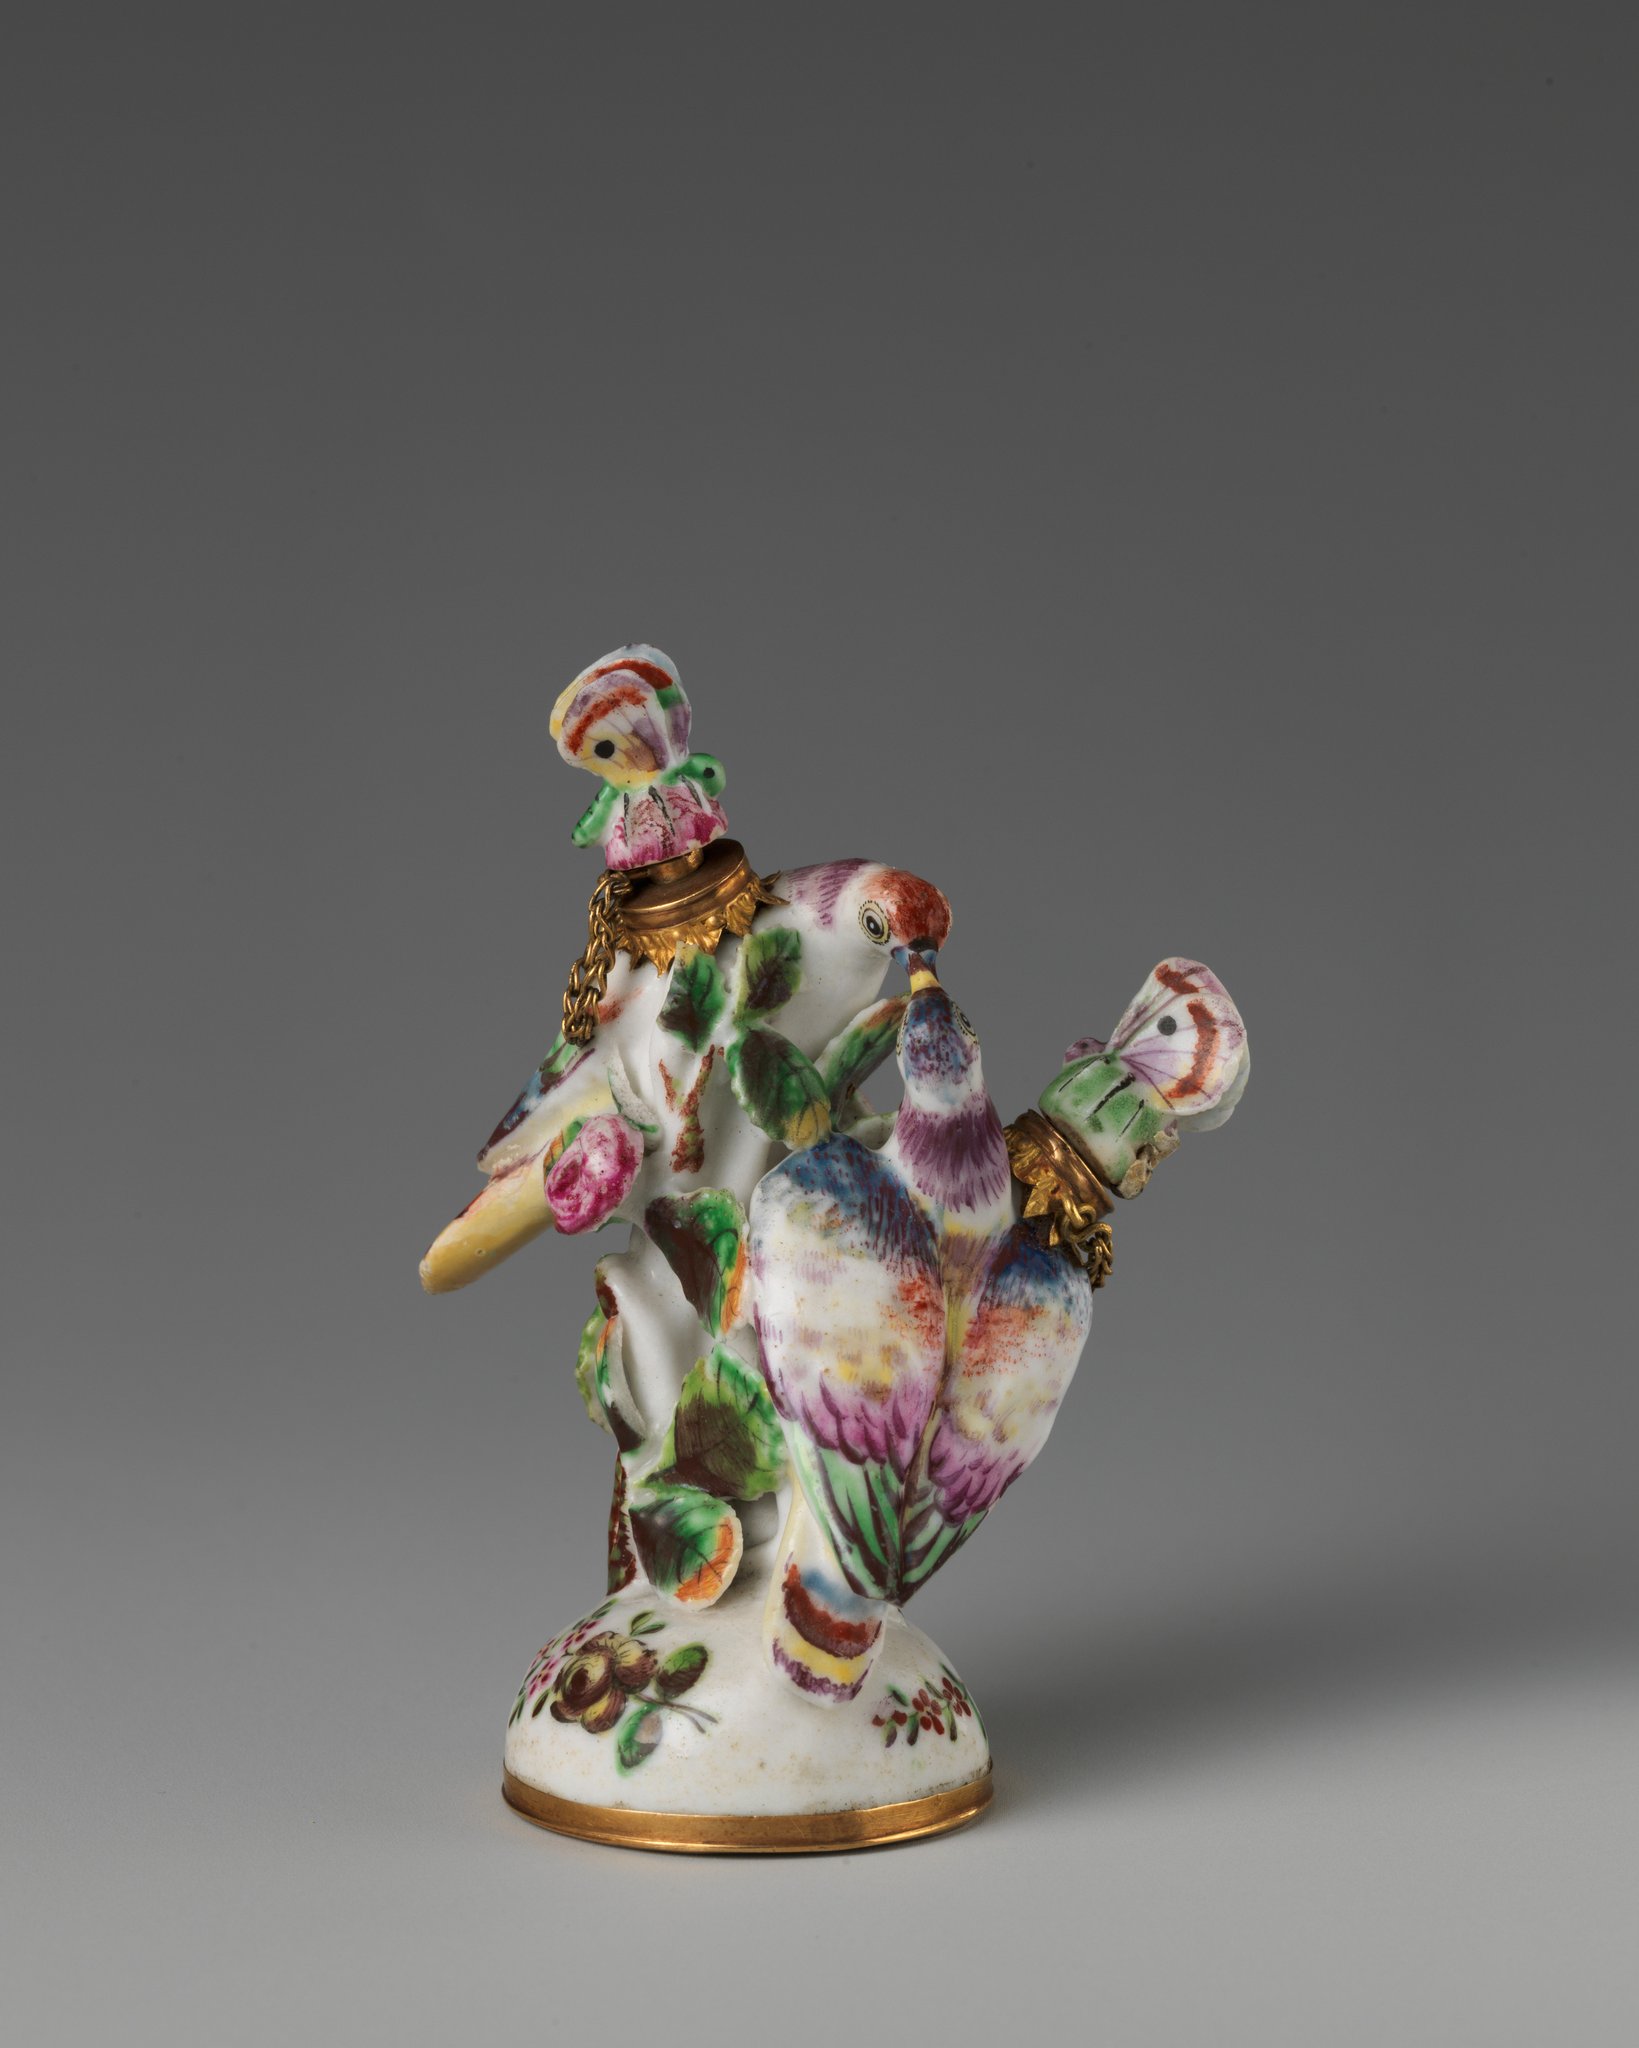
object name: toy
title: Two doves in a group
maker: saint james's factory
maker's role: maker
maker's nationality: british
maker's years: 1749-1759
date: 1755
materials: soft paste porcelain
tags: doves,butterflies,leaves